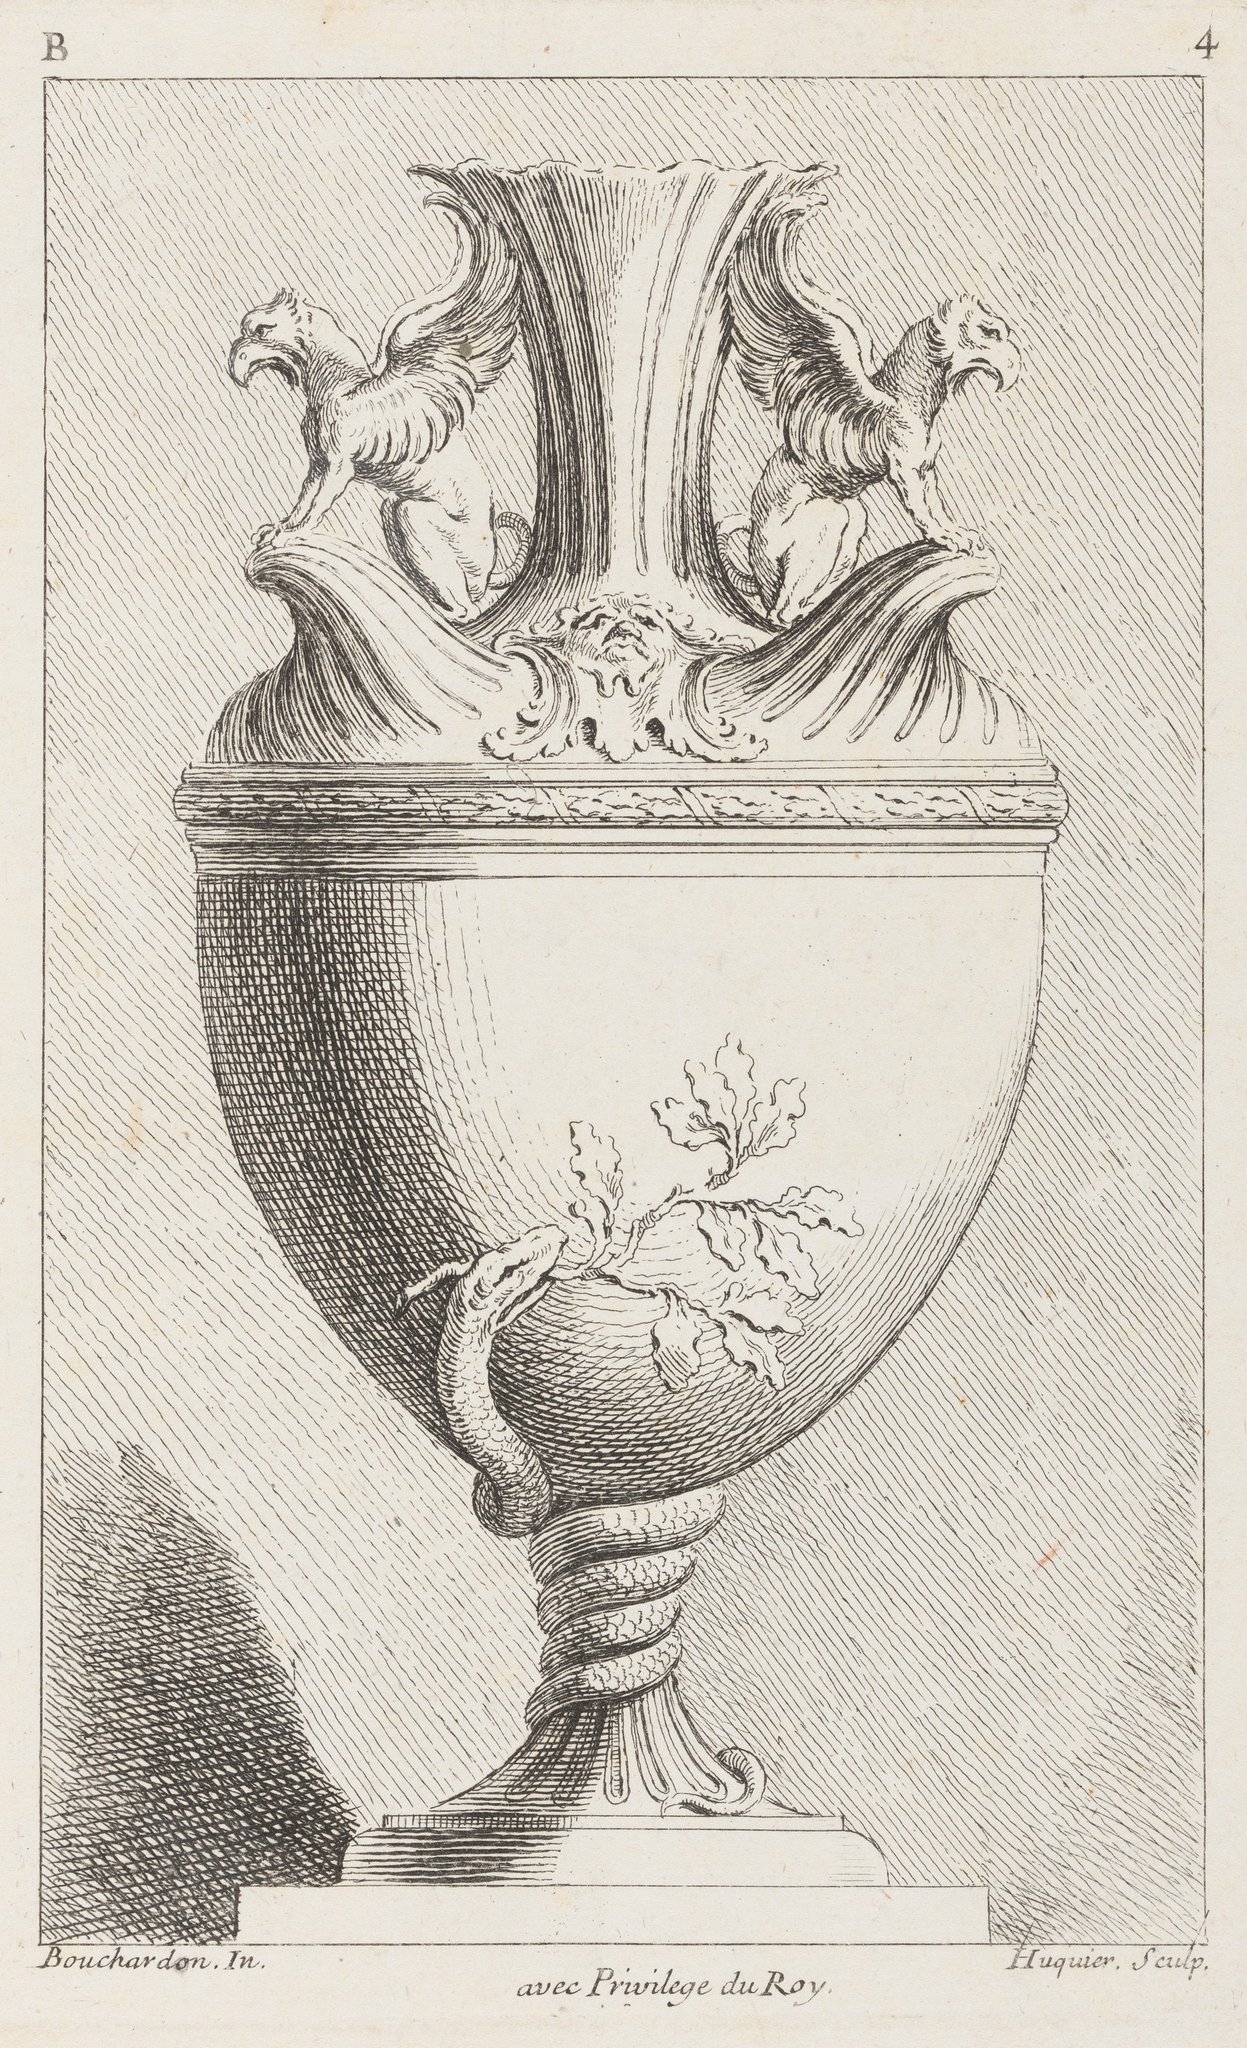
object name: book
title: Second Book of Vases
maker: edme bouchardon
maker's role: artist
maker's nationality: french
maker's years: 1698-1762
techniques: etching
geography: france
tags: vases